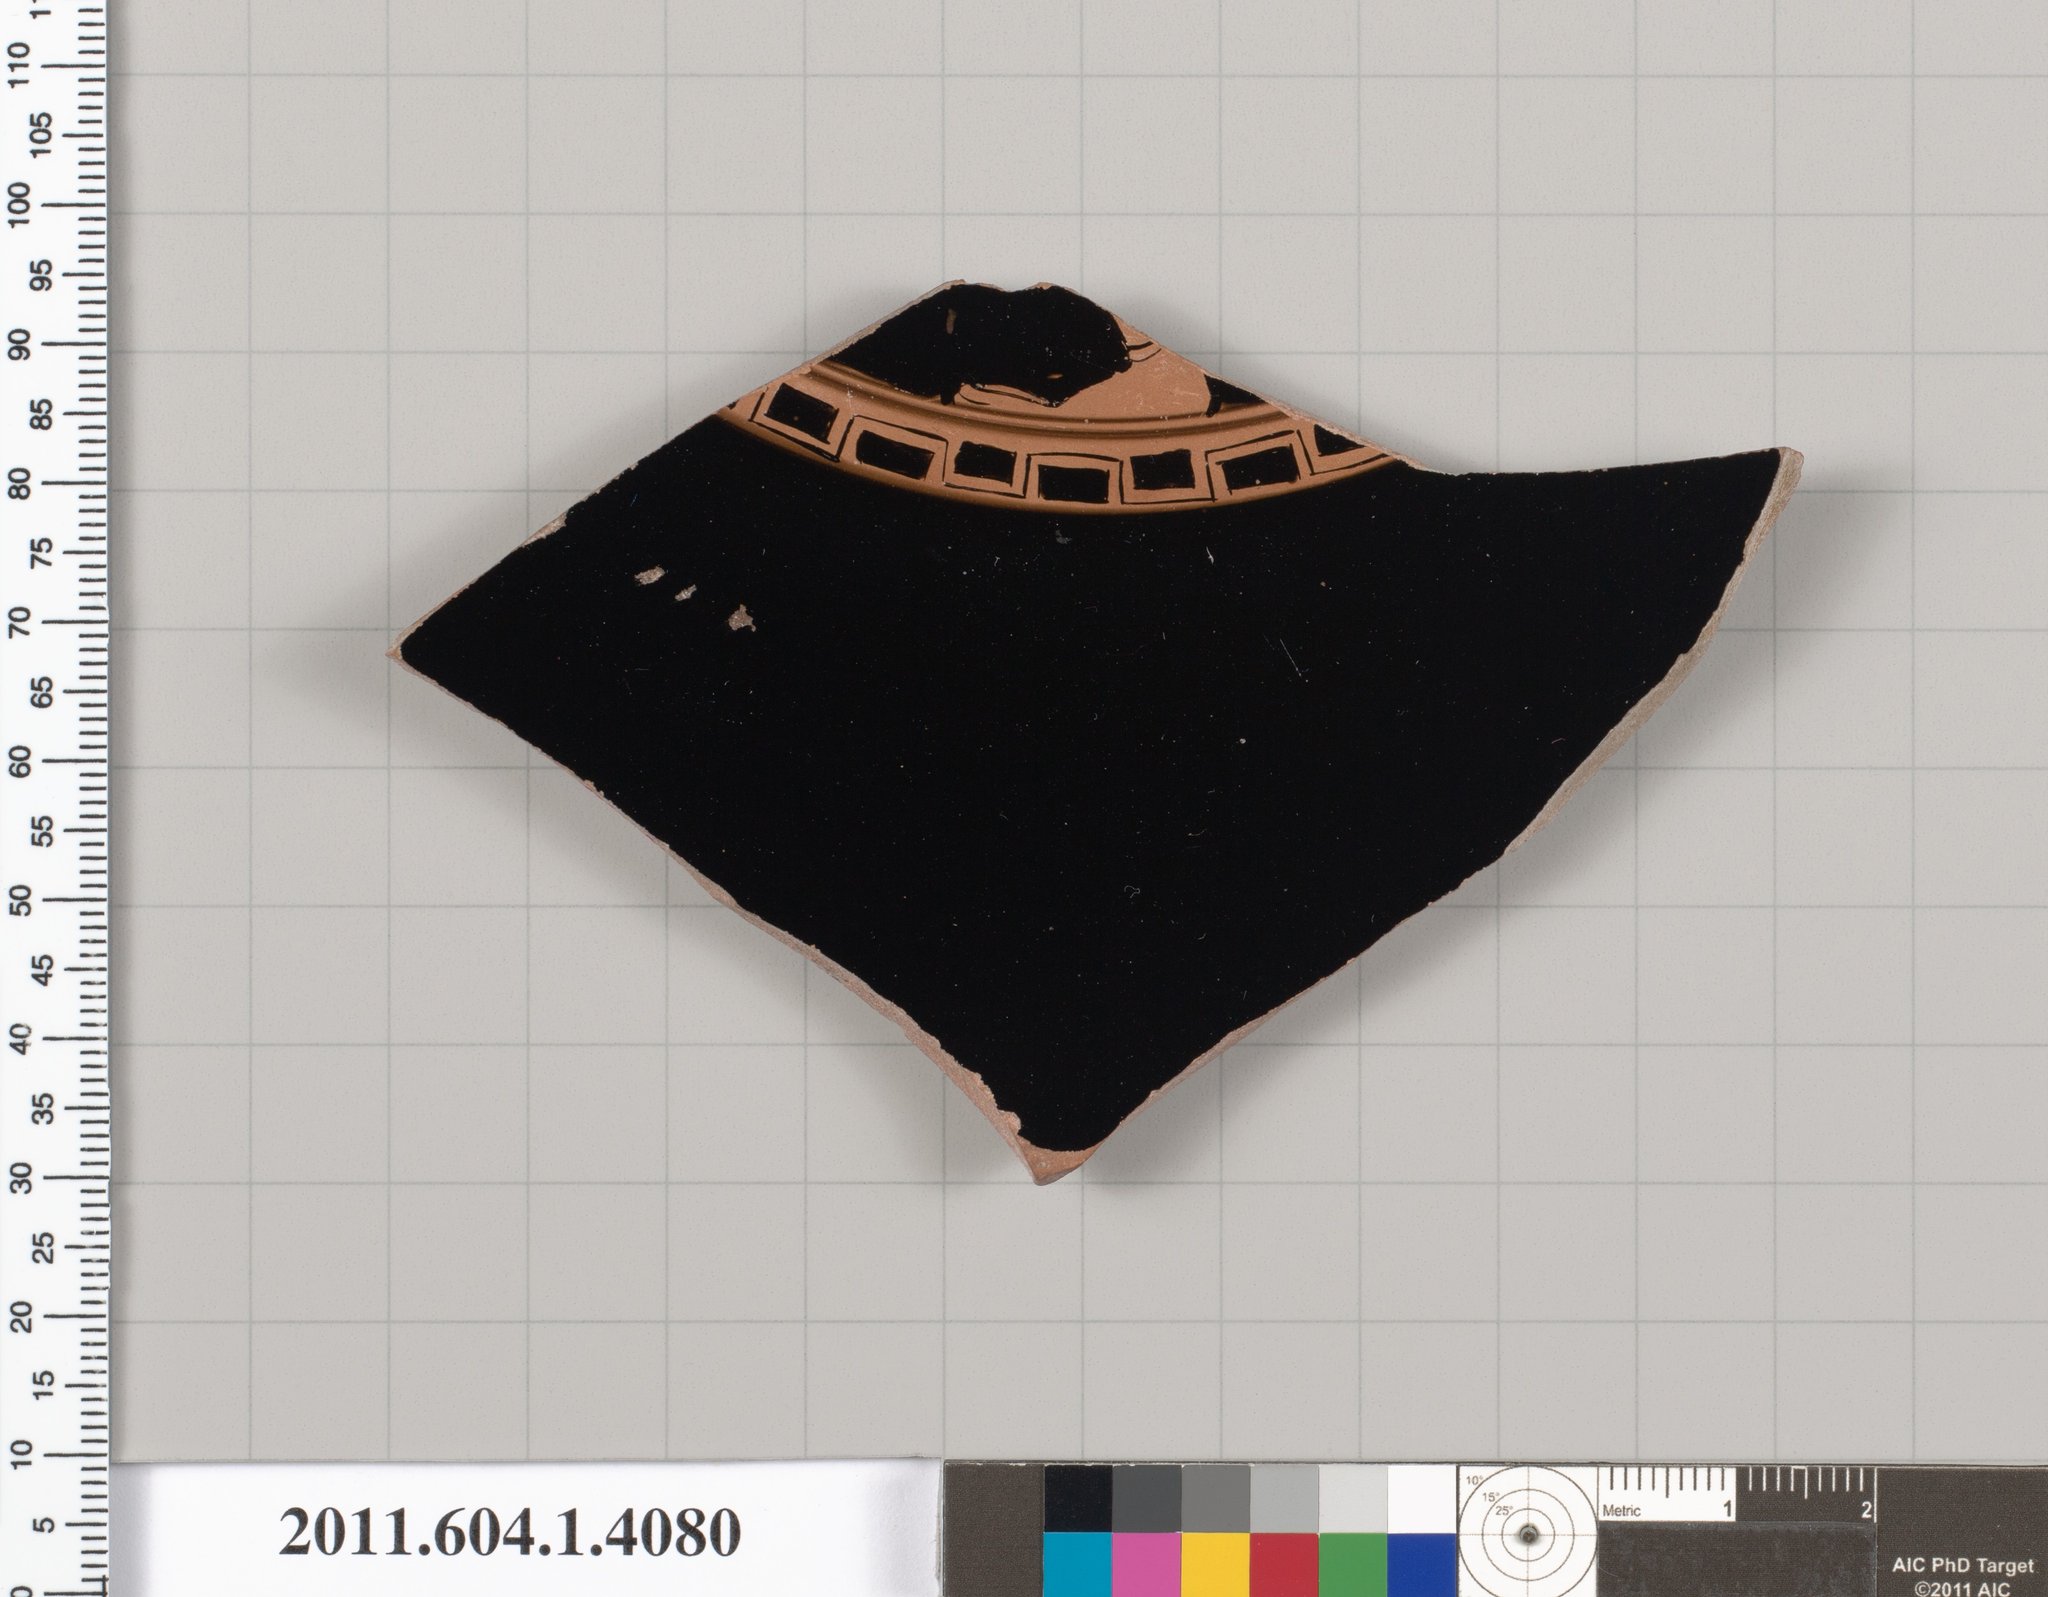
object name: kylix fragment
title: Terracotta fragment of a kylix (drinking cup)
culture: greek, attic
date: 520-500 BCE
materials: terracotta